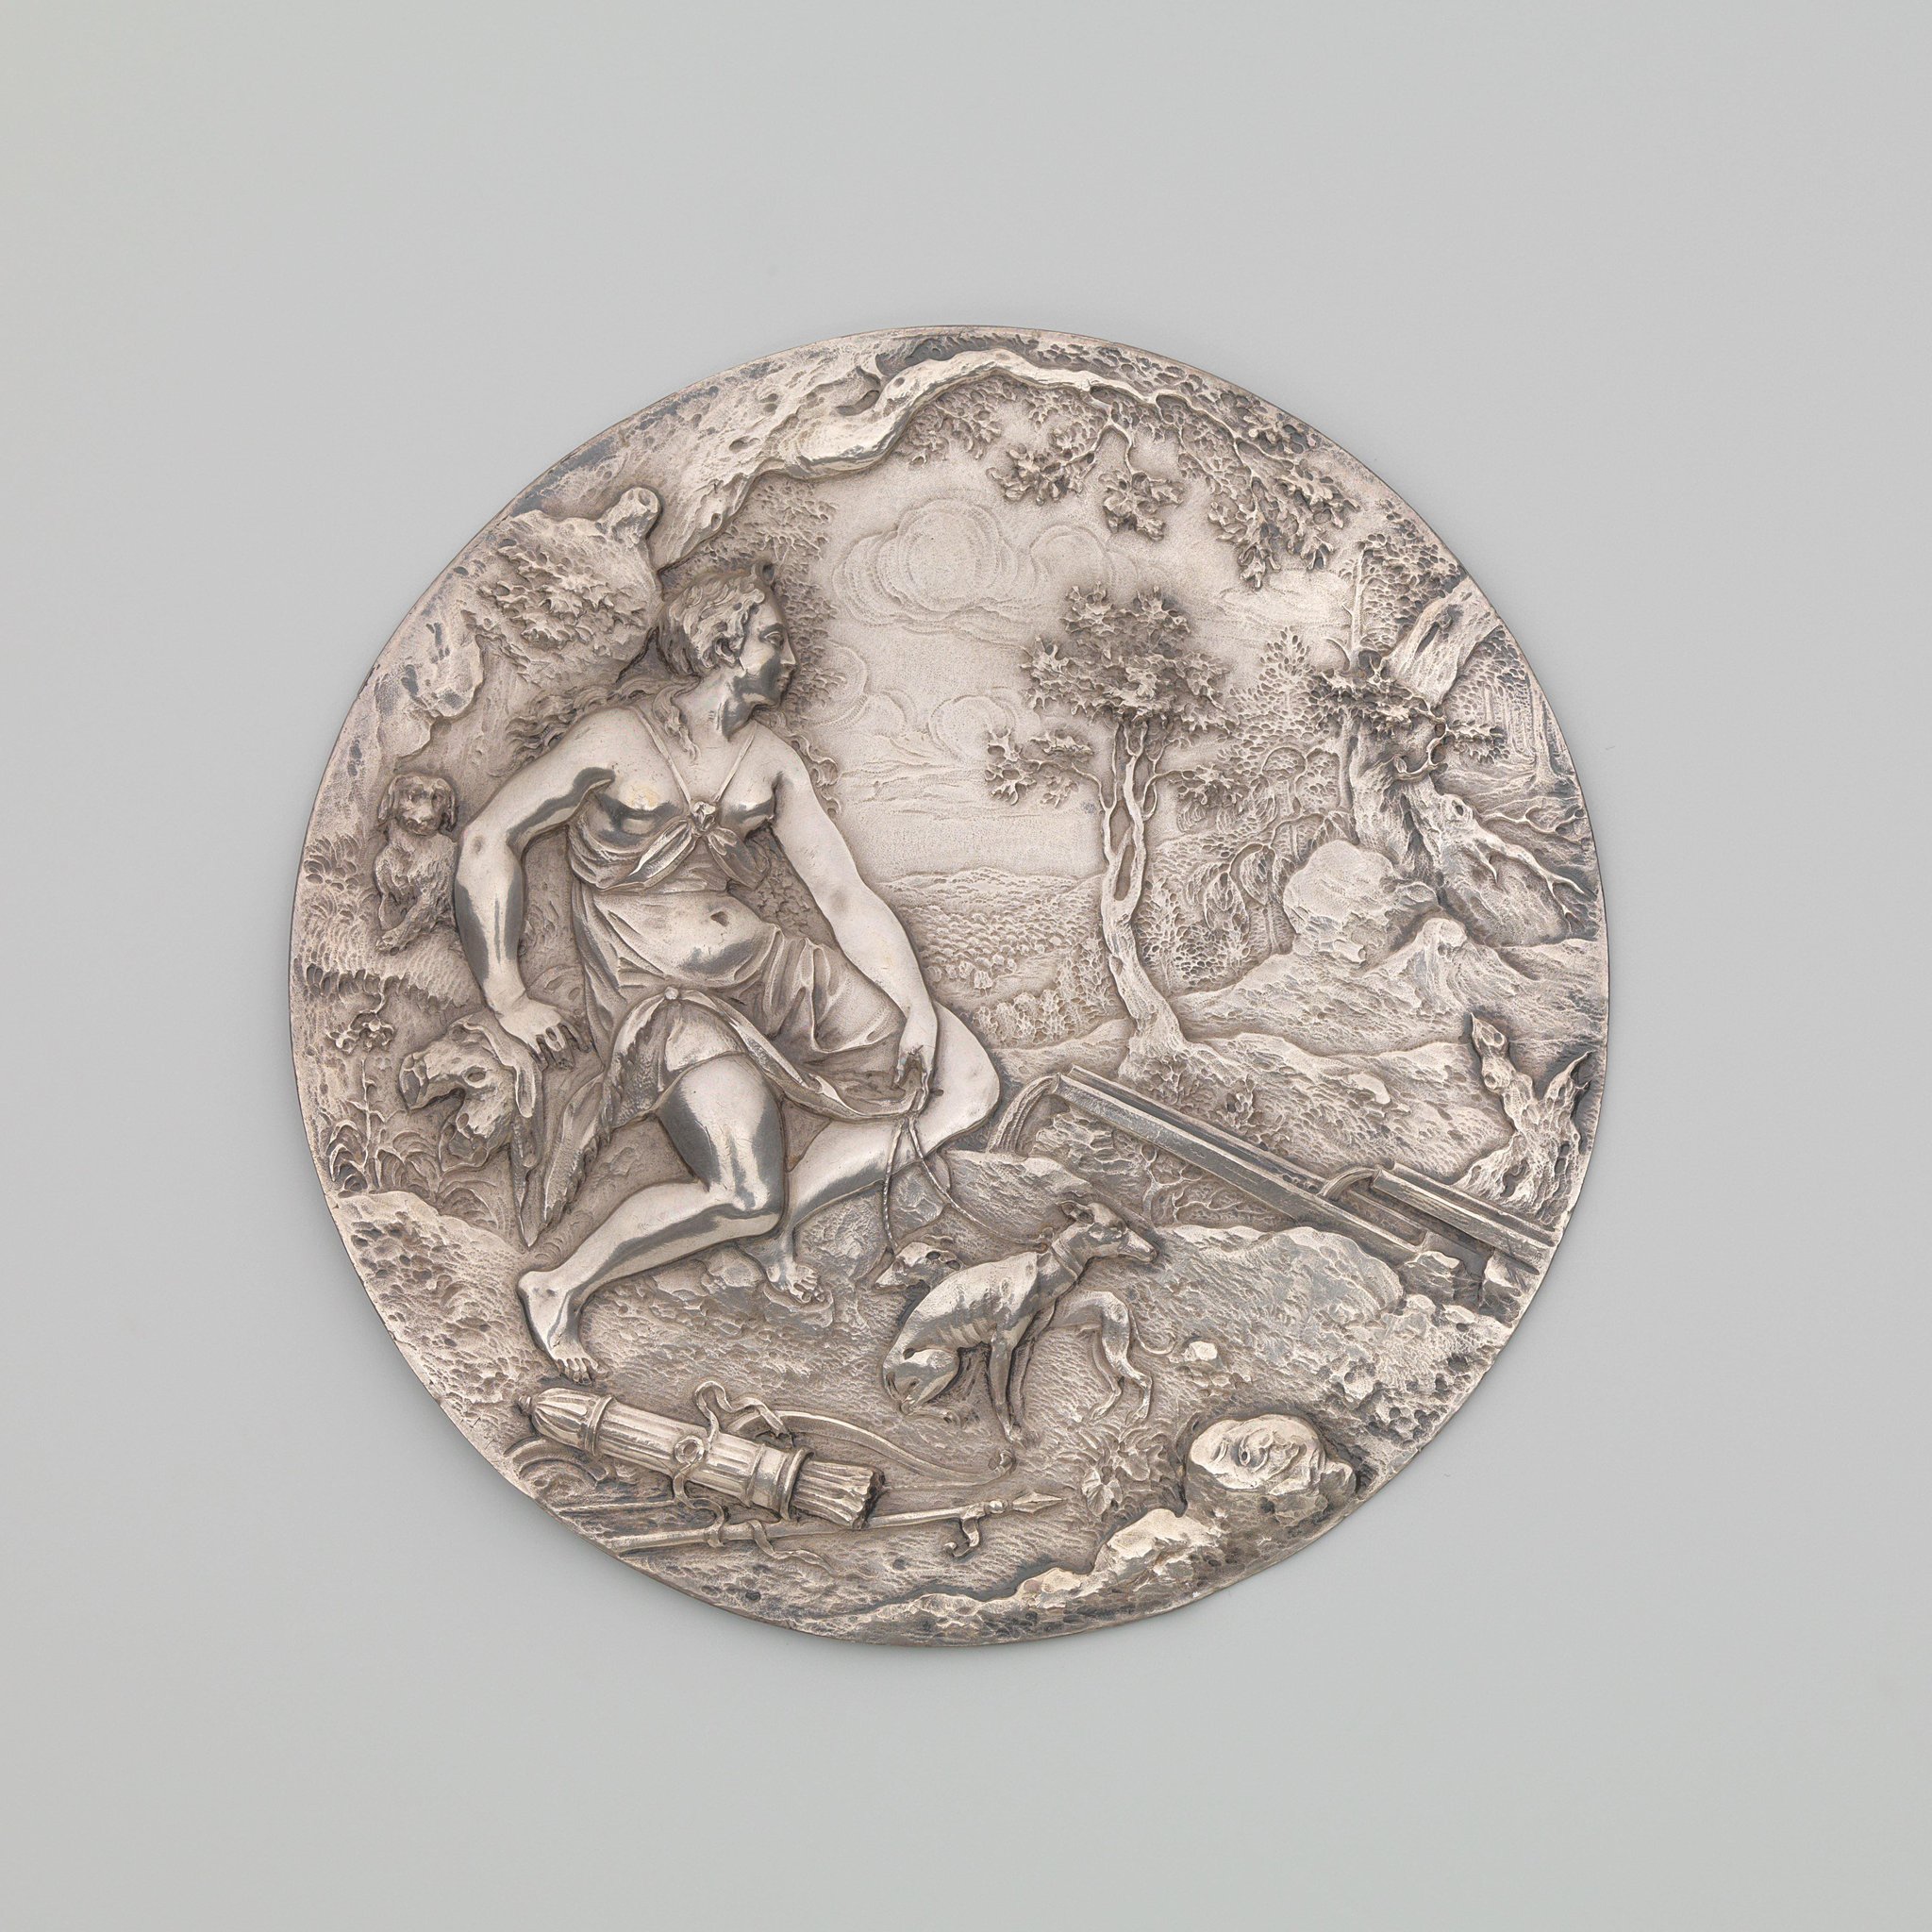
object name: plaque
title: Diana, rustend bij een bron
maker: paulus willemsz. van vianen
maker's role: draughtsman, jeweler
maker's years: 1570-1614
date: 1659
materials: silver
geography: utrecht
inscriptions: date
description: Ronde, zilveren plaquette. De godin zit ter linker zijde van een rotsige terreinverhoging, onder geboomte. In haar linkerhand houdt zij de riemen van haar beide jachthonden. Een langharig hondje zit achter haar. Aan haar voeten de pijlkoker met pijl en boog. Rechts twee afvoergoten van de bron. Heuvelachtig landschap met bomen.